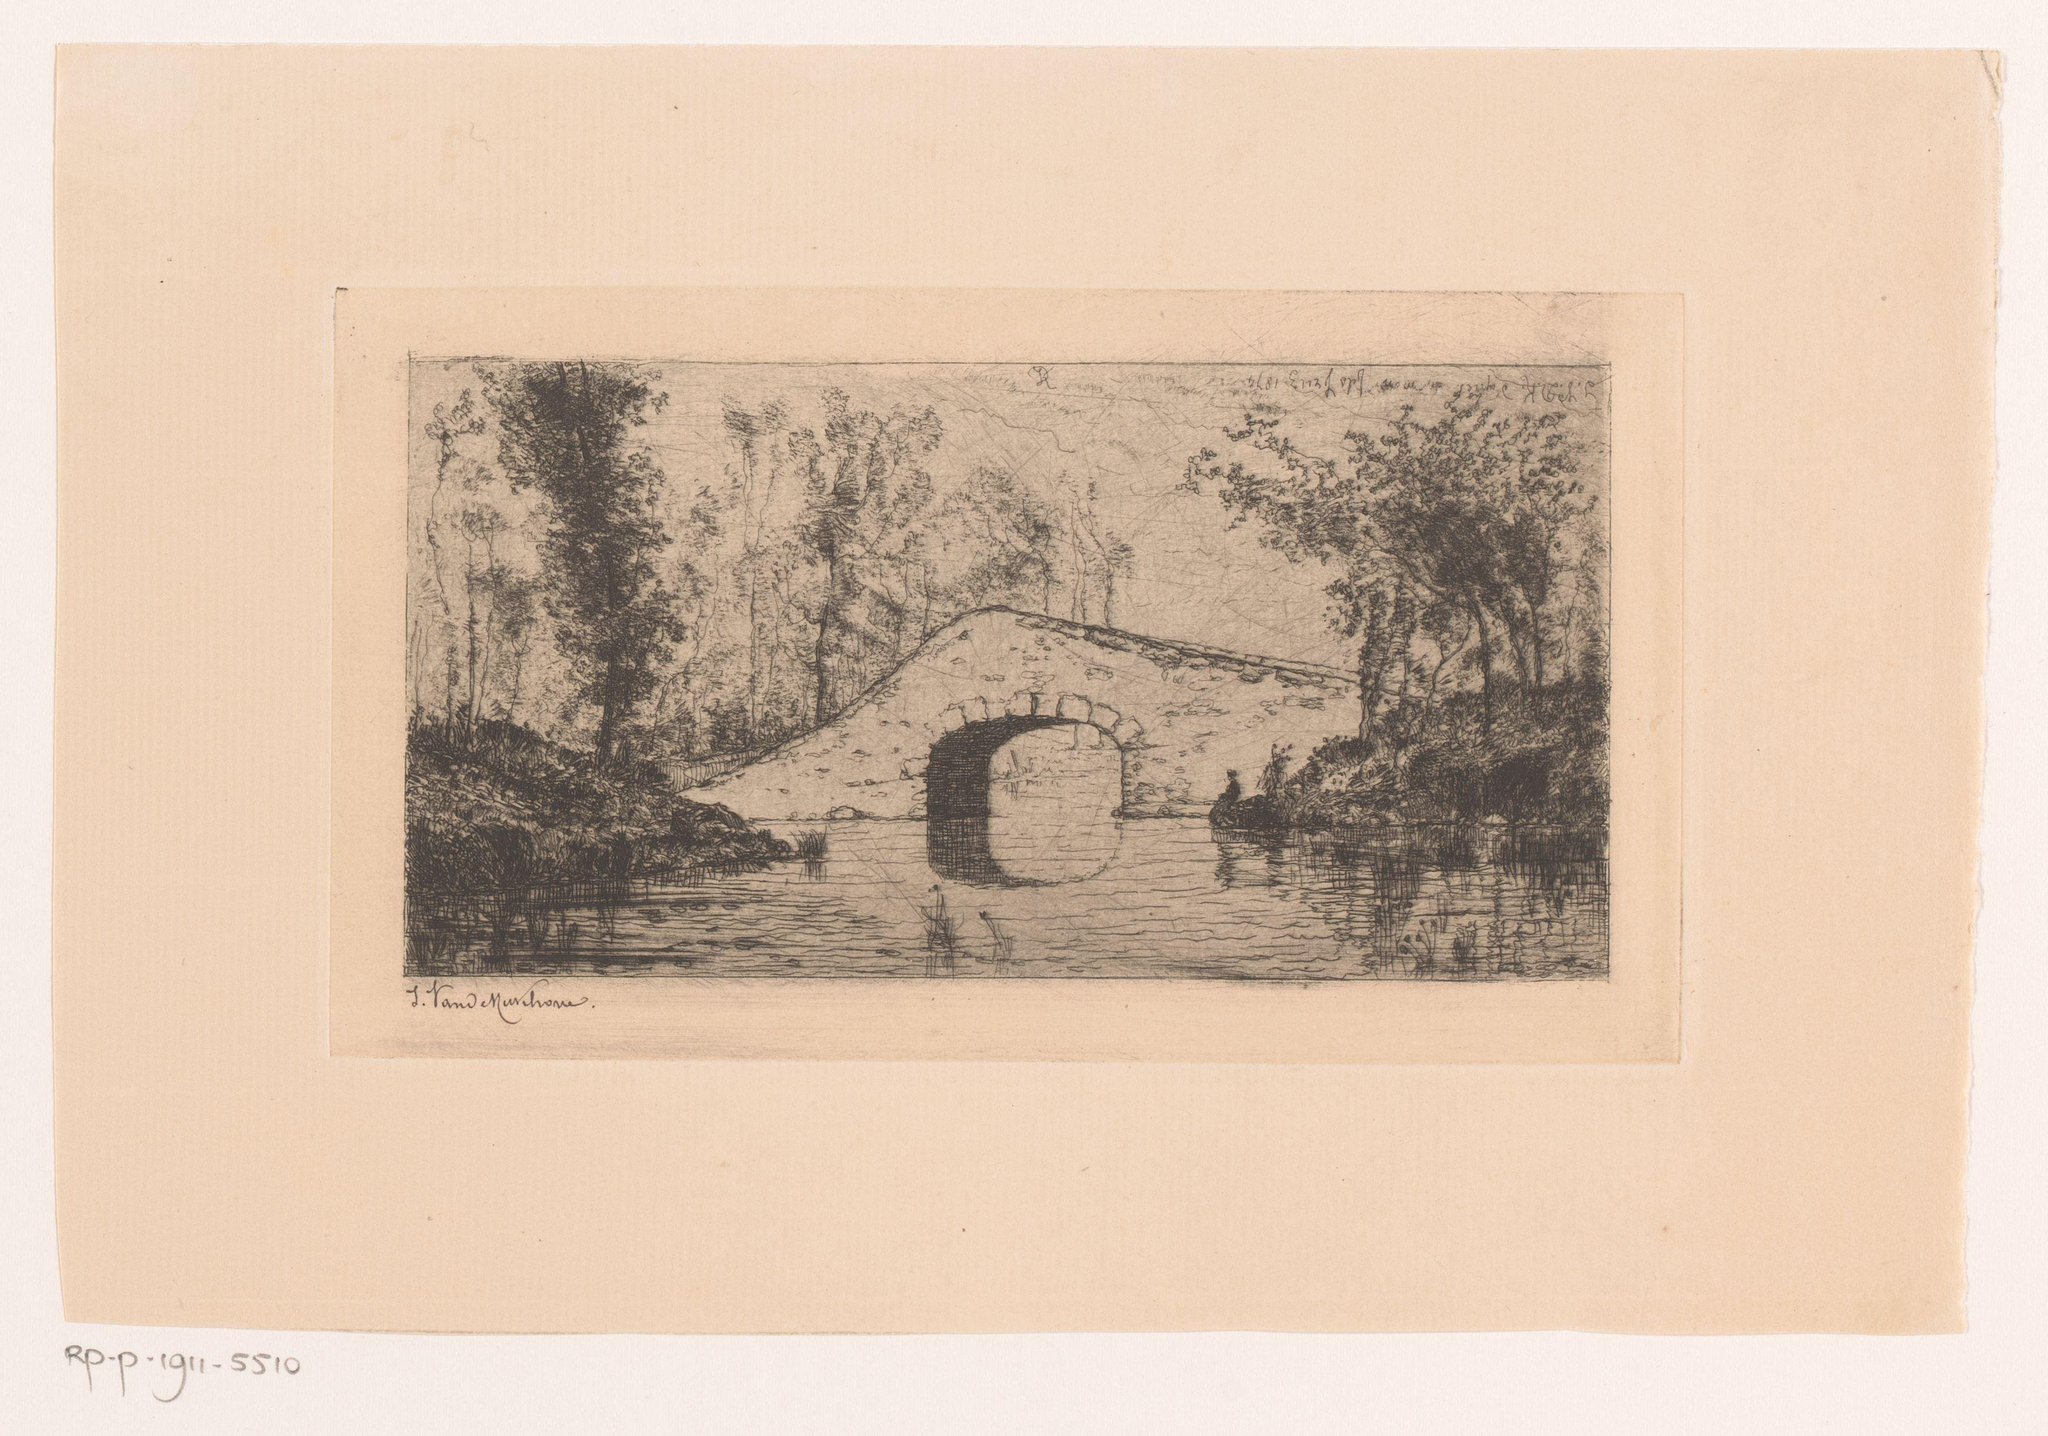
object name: print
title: Grote stenen brug over een rivier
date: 1874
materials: paper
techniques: drypoint, etching, intaglio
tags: landscape with bridge, viaduct or aqueduct, bridge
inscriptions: collector's mark: Lugt 2228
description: De etsen naar de schilderijen van Frédéric Van de Kerkhove werden na zijn dood door zijn vader en zuster gemaakt en uitgegeven in twee reeksen. De eerste werd in 1877 uitgegeven door het Journal des Beaux-Arts et de la Littérature: Cahier de 25 Eaux-fortes d'après Frédéric van de Kerkhove, gravées par son père et sa sœur. De tweede reeks van 126 etsen, ook in 1877, werd in Parijs uitgegeven bij A. Lévy onder de titel Cent eaux-fortes gravées par J. Van de Kerkhove d'après les tableaux de Frédéric Van de Kerkhove, mort en 1873 à l'âge de 10 ans et 11 mois.